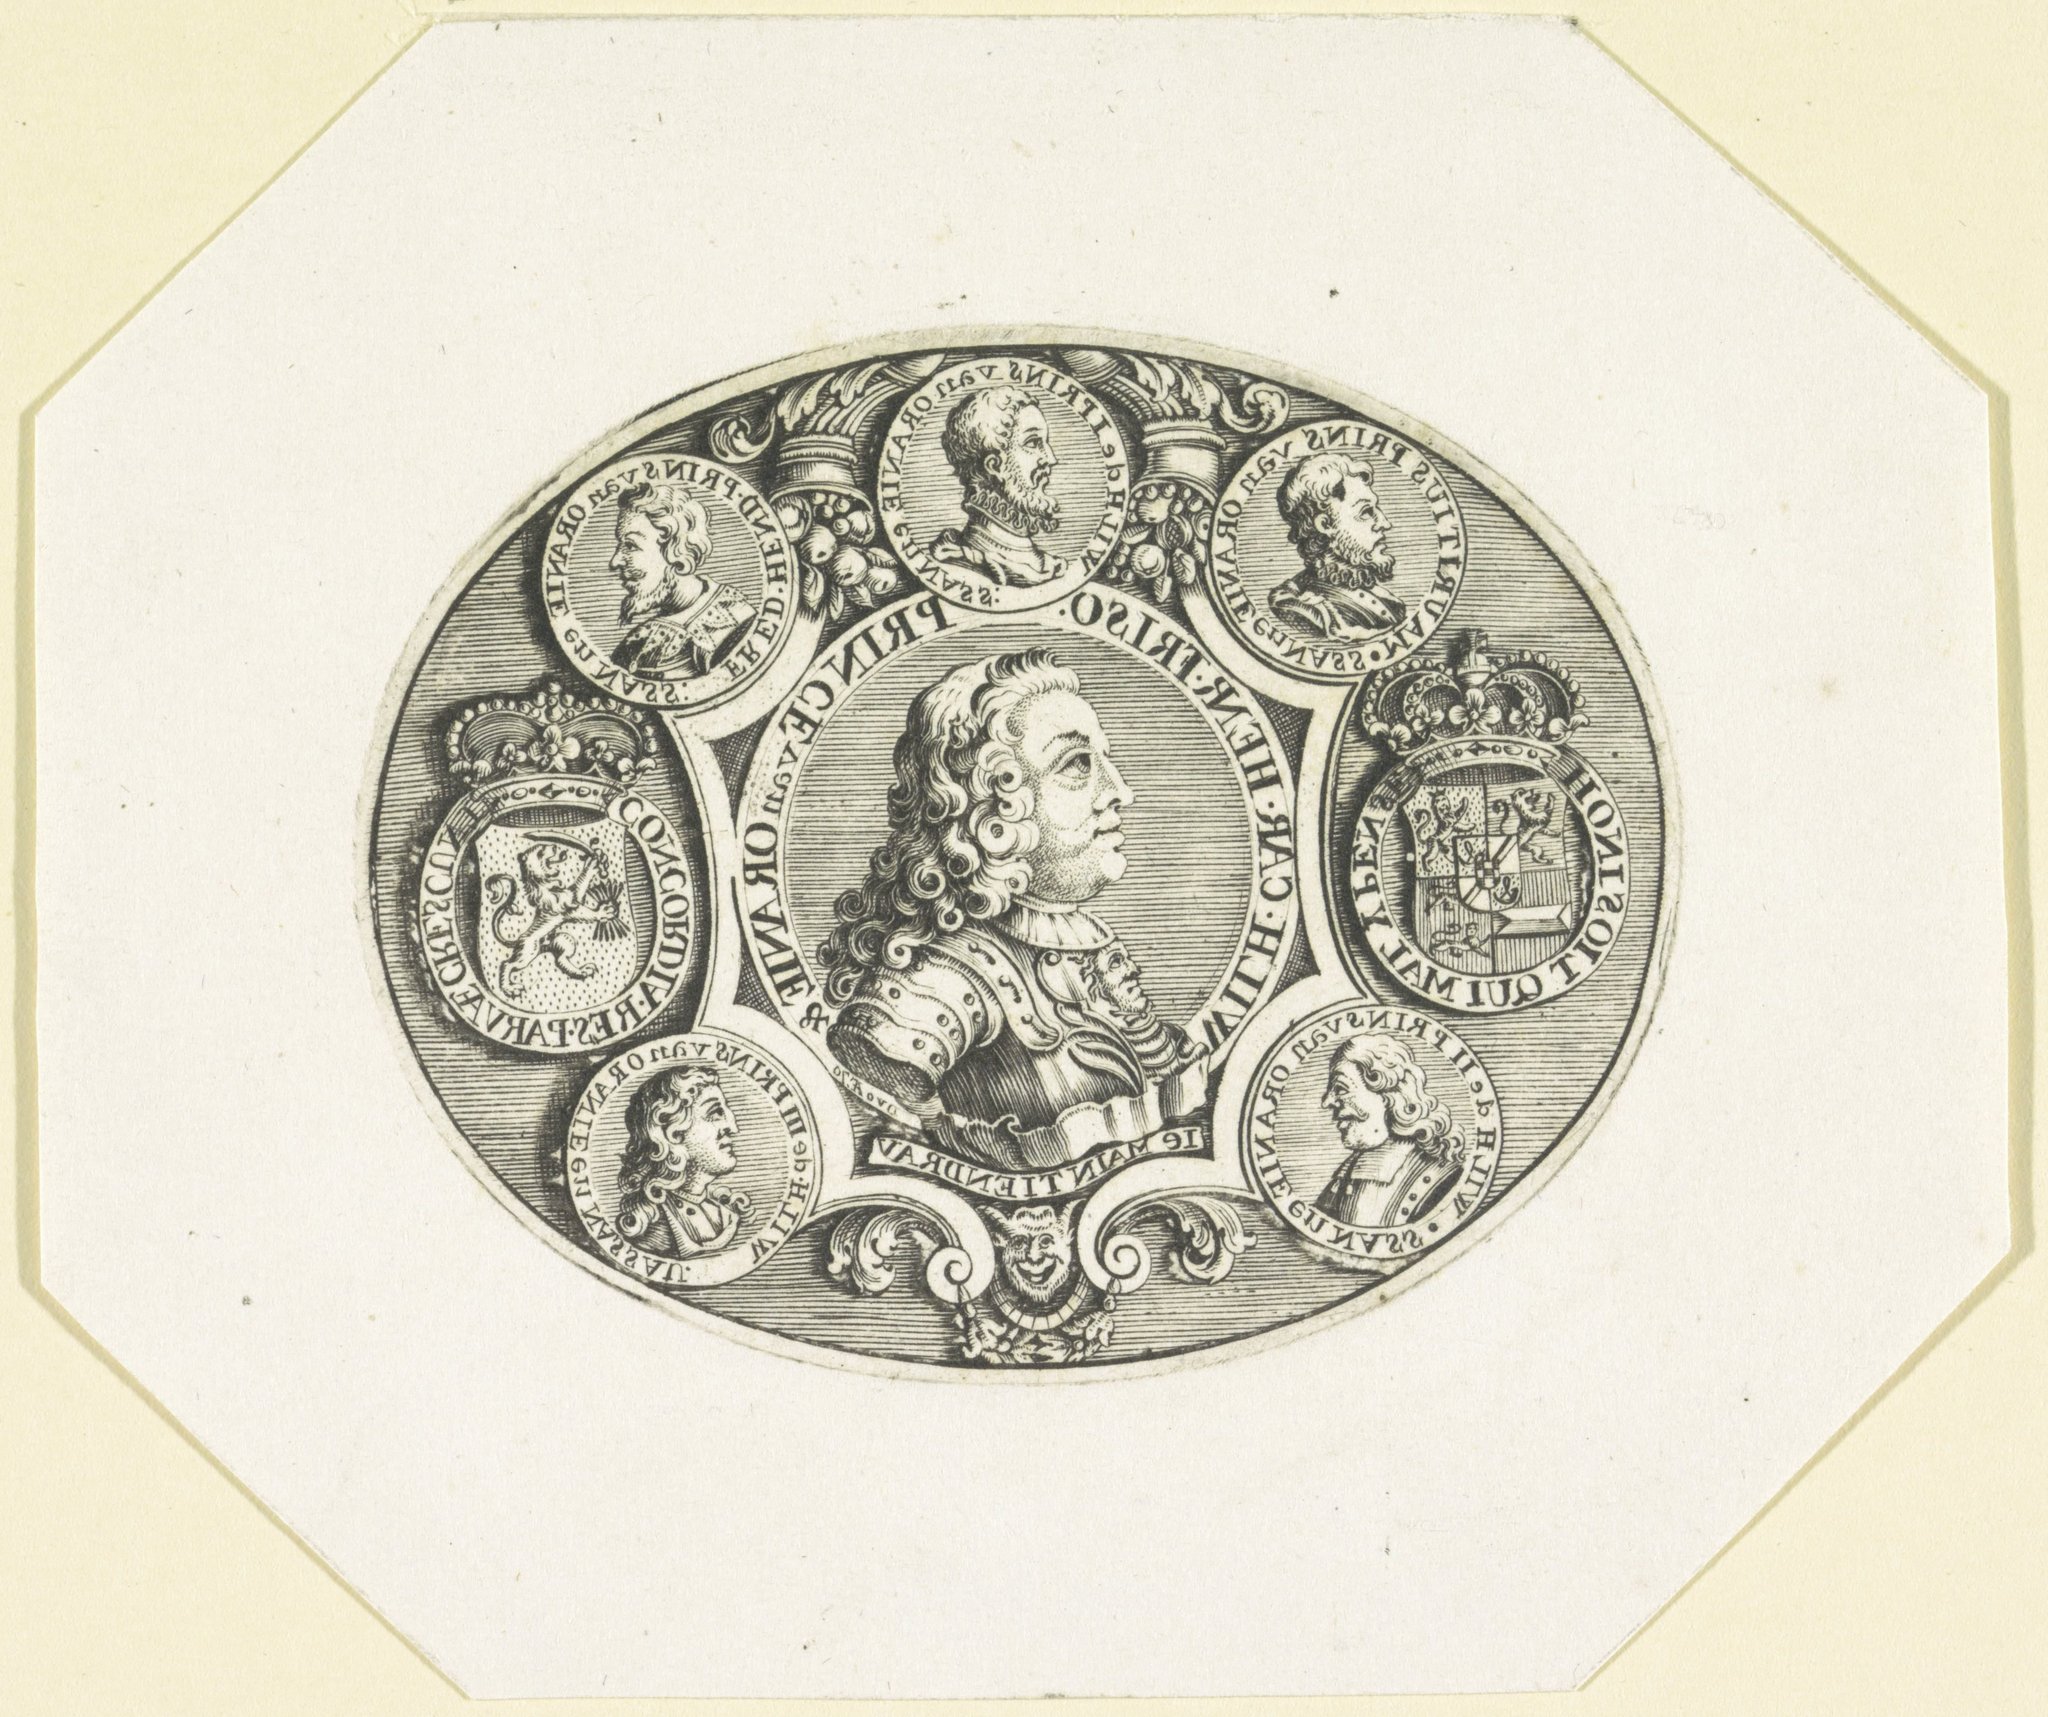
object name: print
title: Portret van Willem IV, prins van Oranje-Nassau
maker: Anonymous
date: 1747-1799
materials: paper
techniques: engraving, etching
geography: low countries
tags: william iii (prince of orange and king of england, scotland, and ireland), delft, frederick henry (prince of orange), william ii (prince of orange), william i (prince of orange), maurice (prince of orange), willem iv (prins van oranje-nassau), knighthood order (garter) - insignia of a knighthood order, e.g.: badge, chain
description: Portret van Willem IV in een cirkel met randschrift. Daaronder op een banderol zijn geslachtsspreuk. Geheel in een ovale omlijsting met zijn wapen met een kroon, gedecoreerd met de Kousenband en het devies van de Orde van de Kousenband, en portretten van Willem I, Maurits, Frederik Hendrik, Willem II en Willem III, elk in een cirkel met randschrift. In spiegelbeeld.